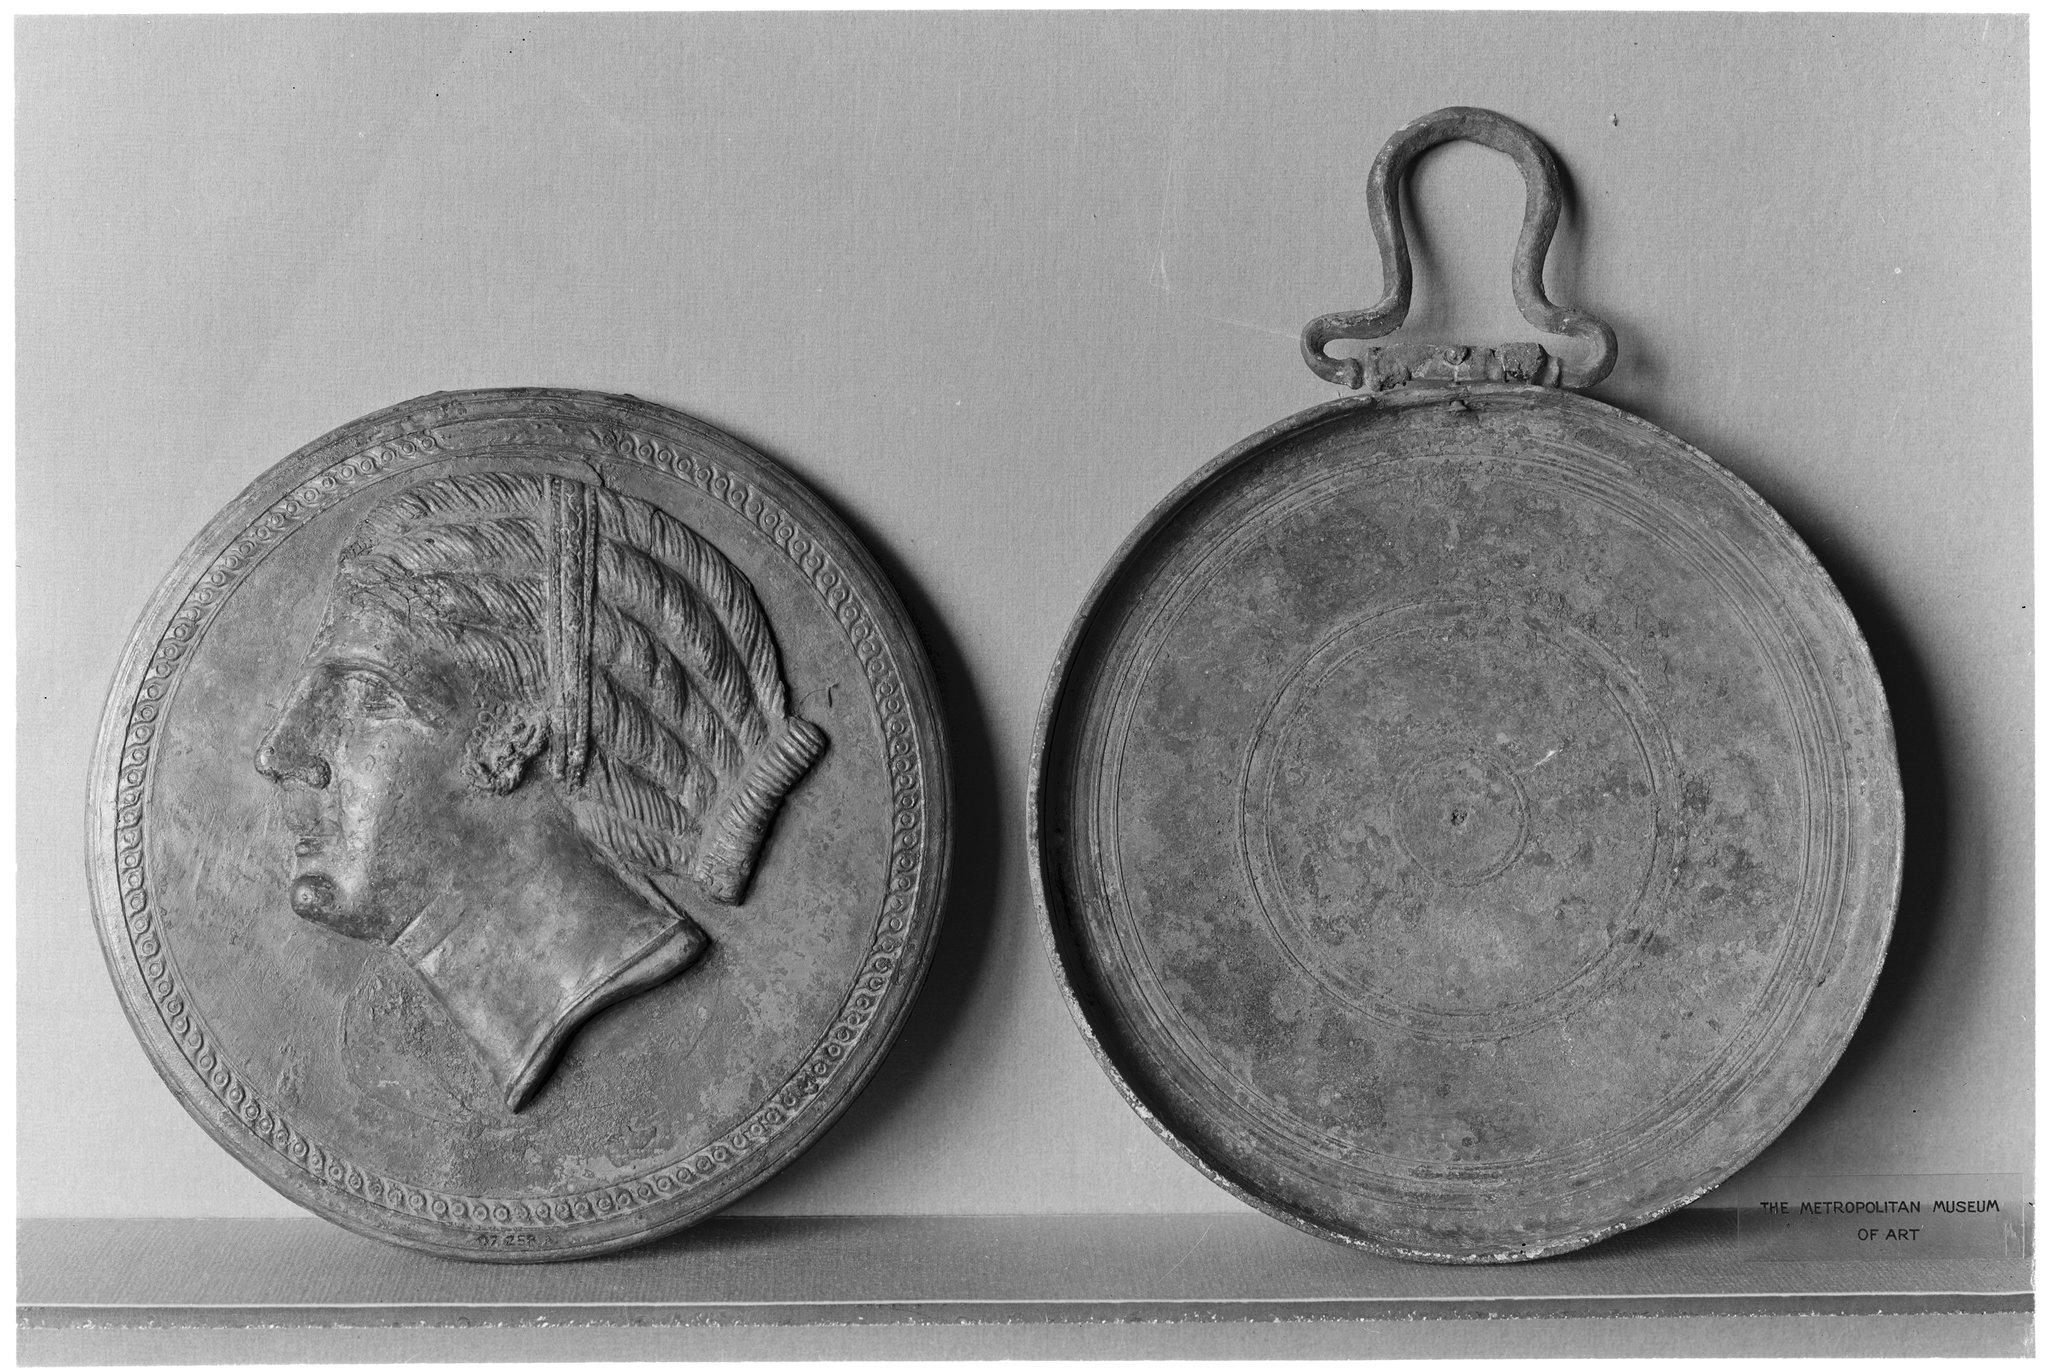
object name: mirror with cover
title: Bronze box mirror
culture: greek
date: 367-335 BCE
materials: bronze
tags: women